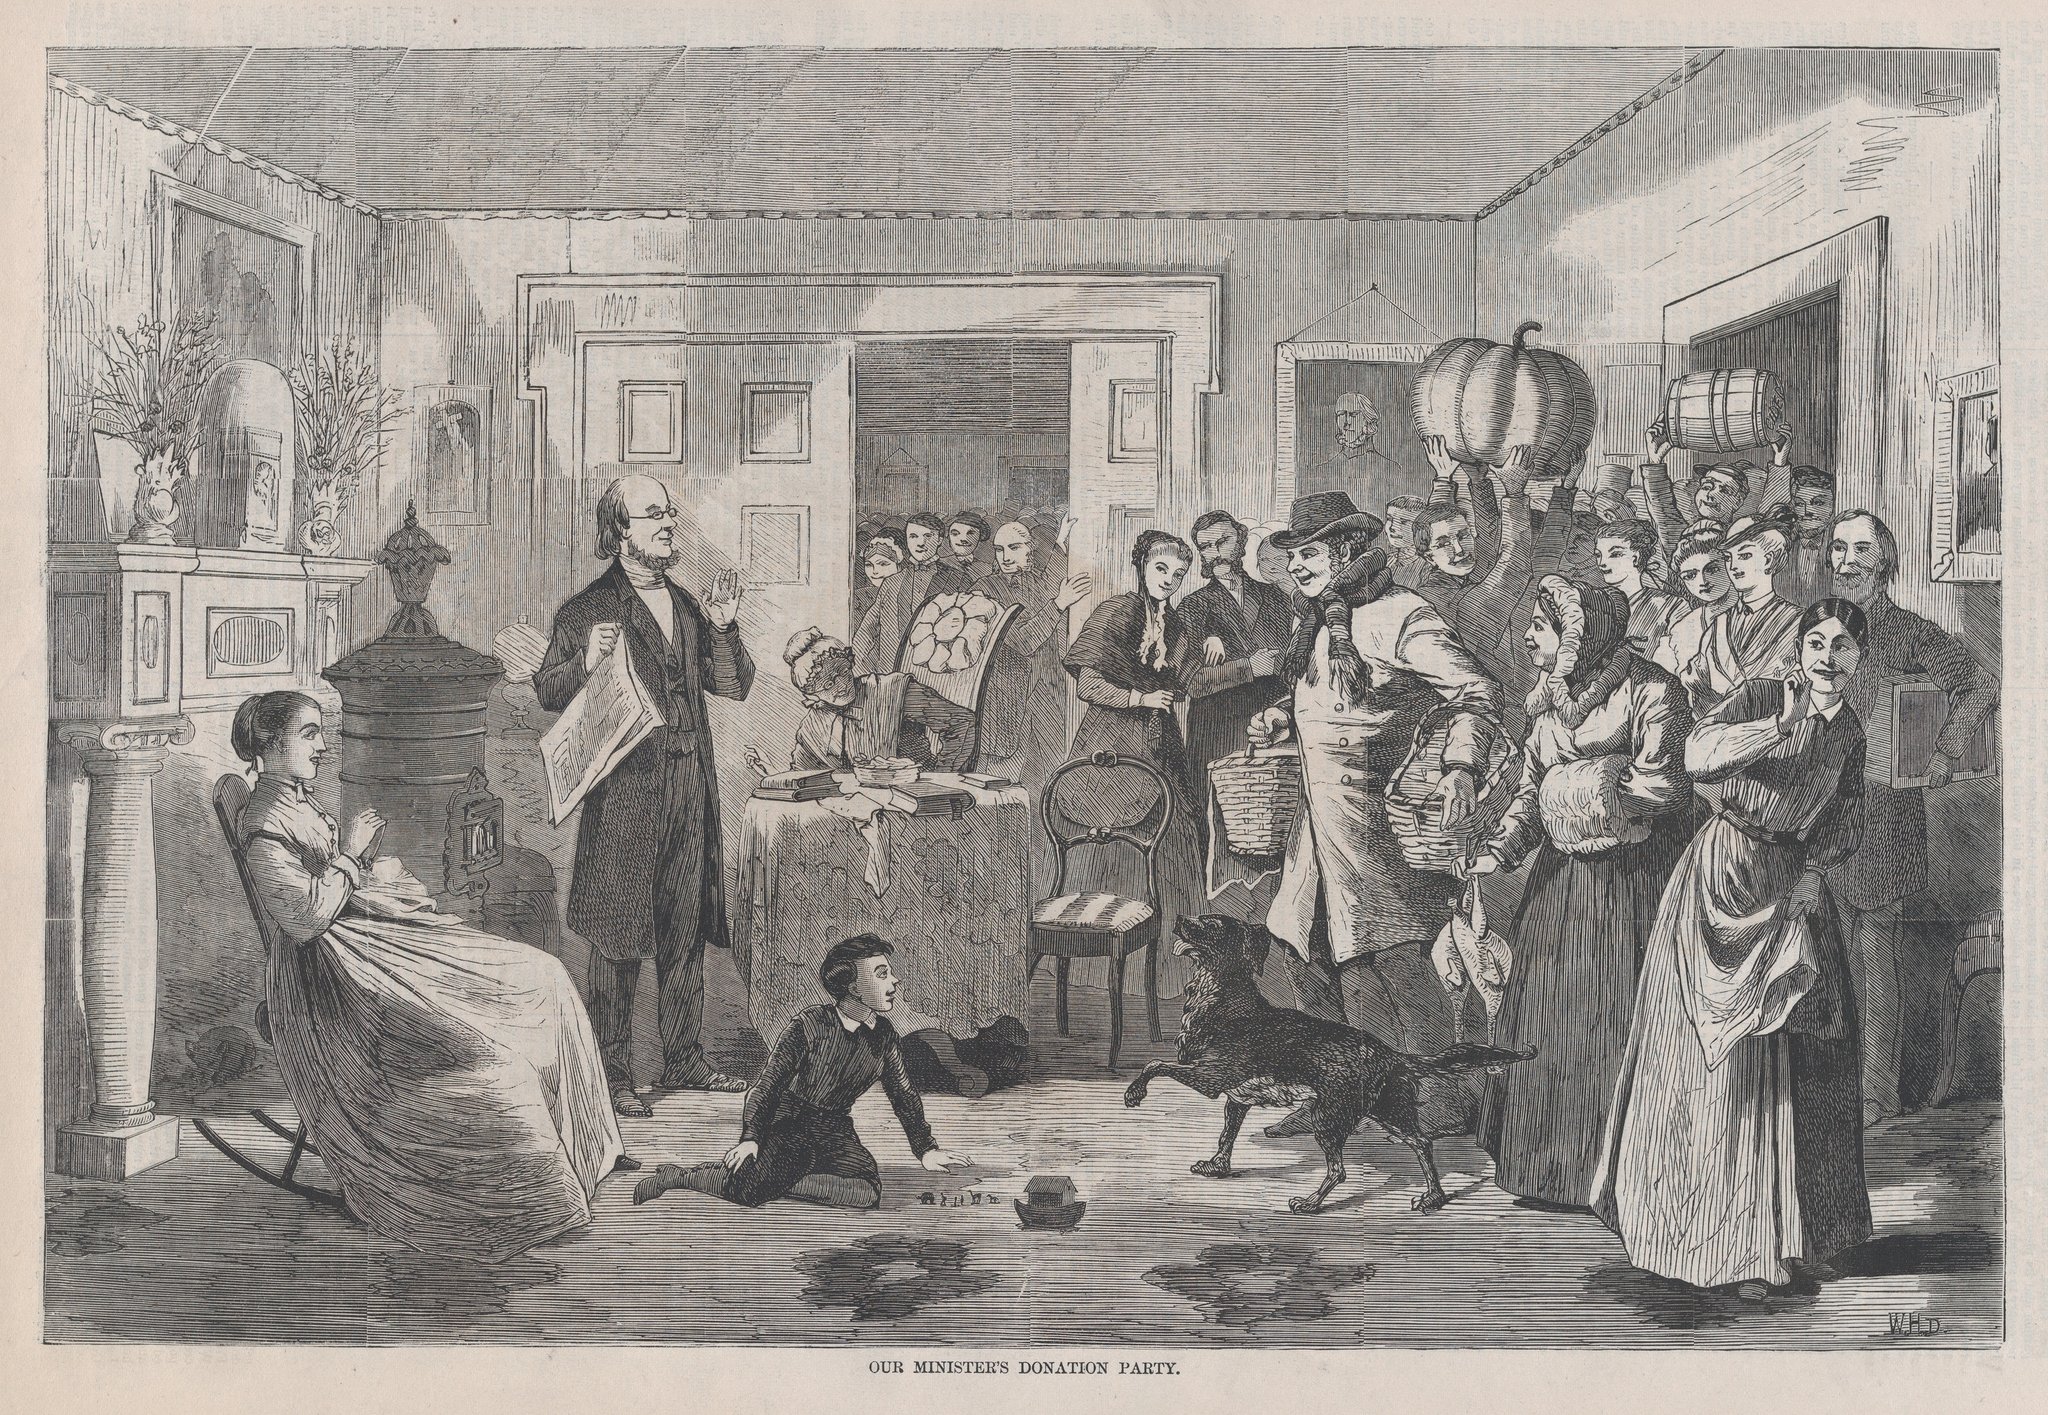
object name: print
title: Our Minister's Donation Party (from "Harper's Bazar," Vol. I)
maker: winslow homer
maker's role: artist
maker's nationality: american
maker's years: 1836-1910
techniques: engraving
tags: interiors,boys,men,women,party,dogs,crowd,baskets